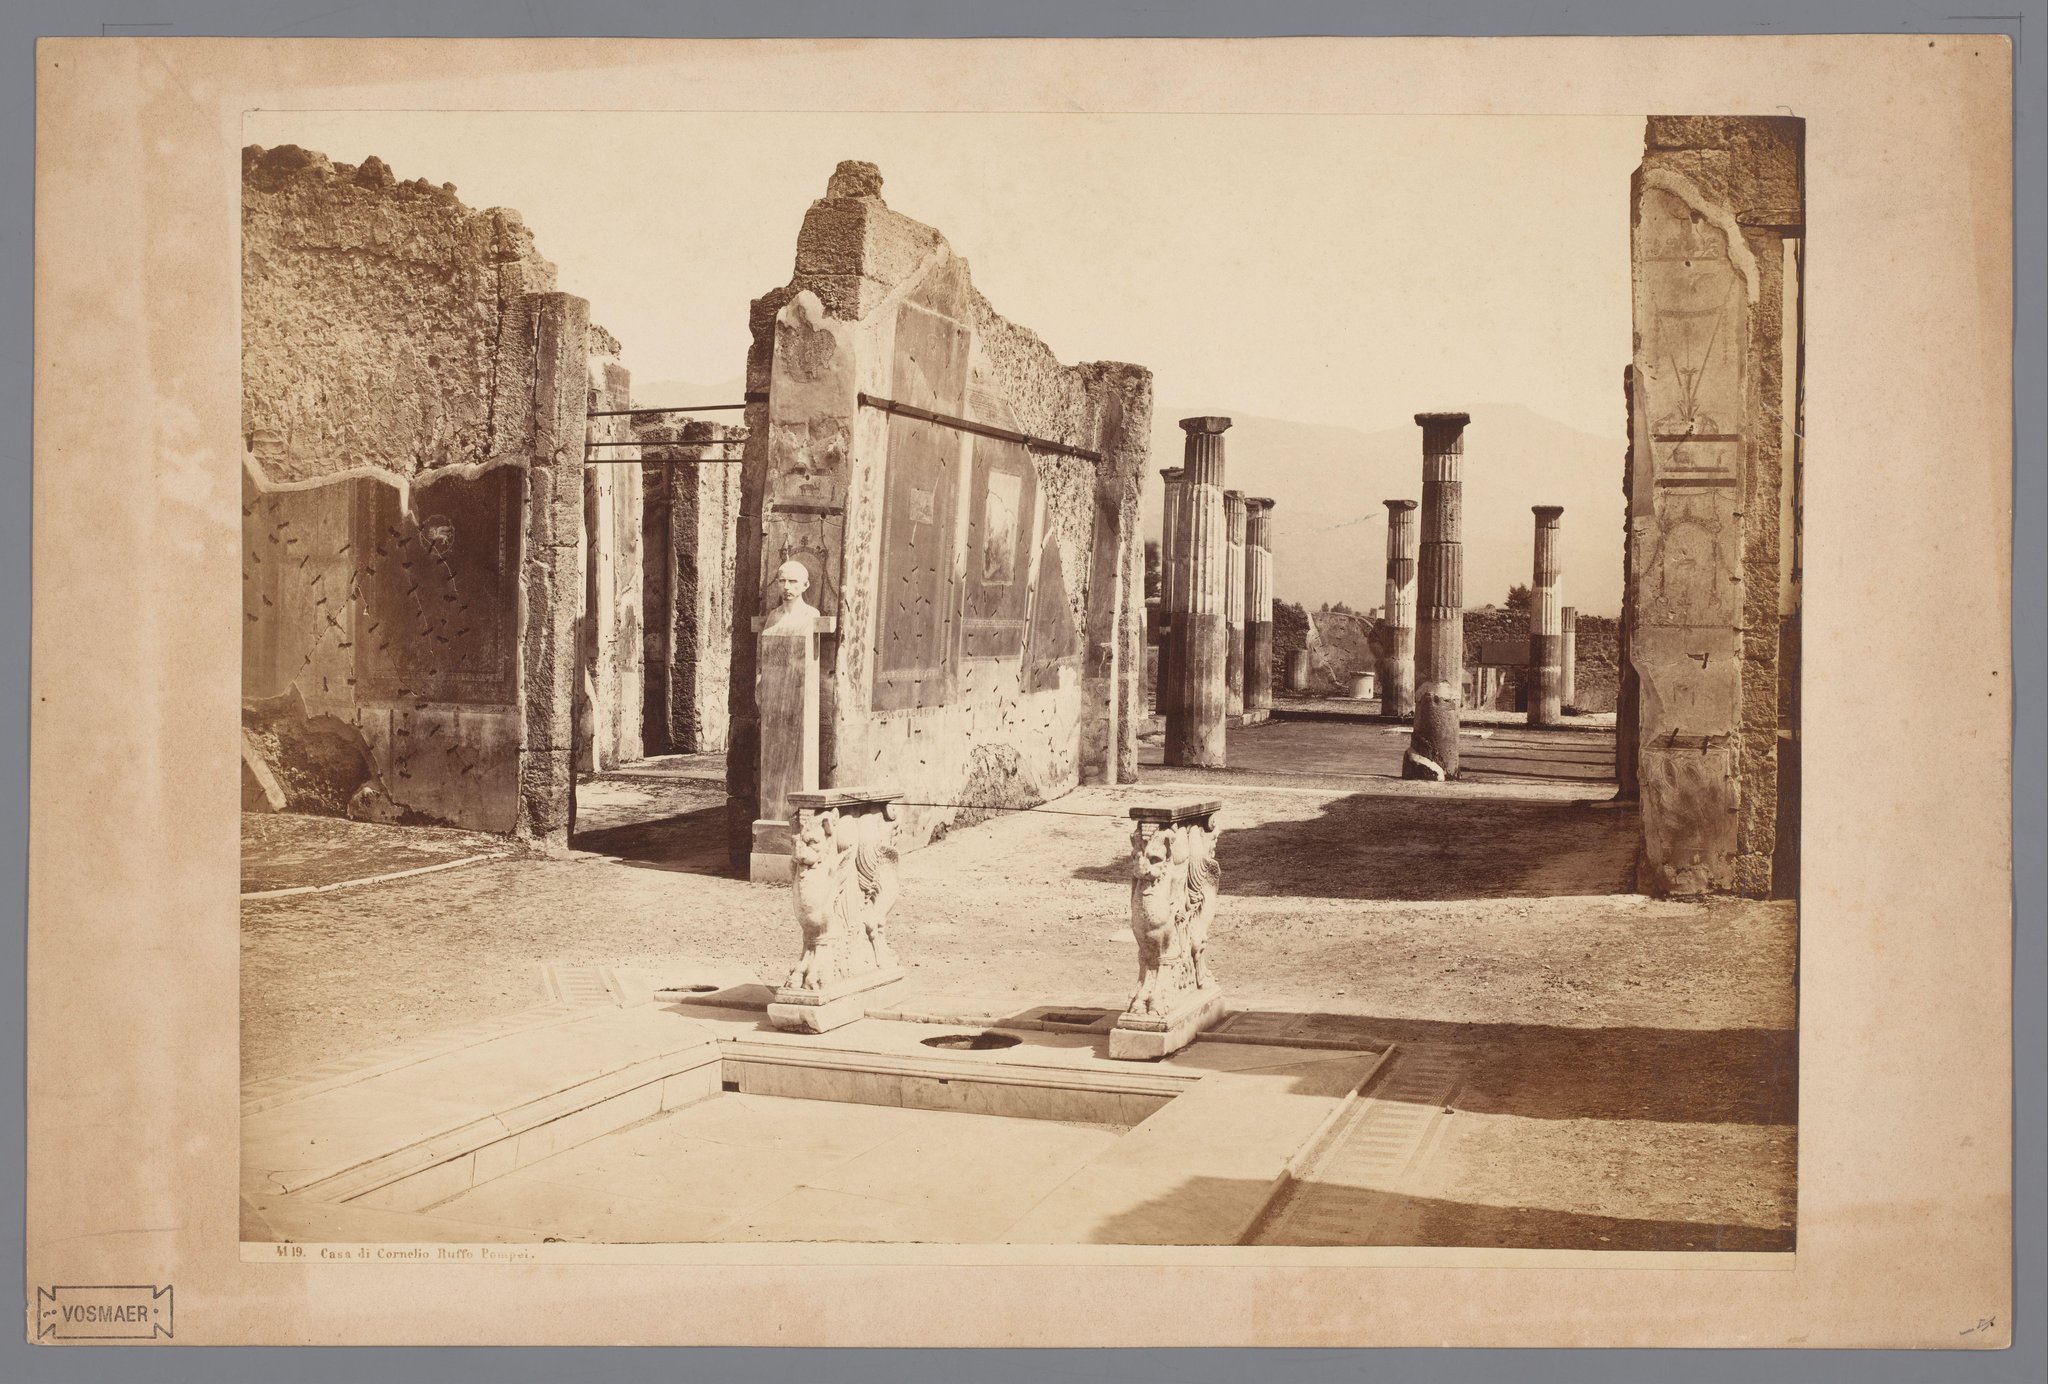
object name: photograph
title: Restanten van het huis van Cornelio Rufo te Pompeï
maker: giorgio sommer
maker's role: fotograaf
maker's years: 1834-1914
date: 1857-1875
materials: cardboard, paper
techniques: albumen print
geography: pompeii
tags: urban housing, ruin of a building ~ architecture, landscape with ruins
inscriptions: collector's mark: ‘VOSMAER’, number: ‘4119.’